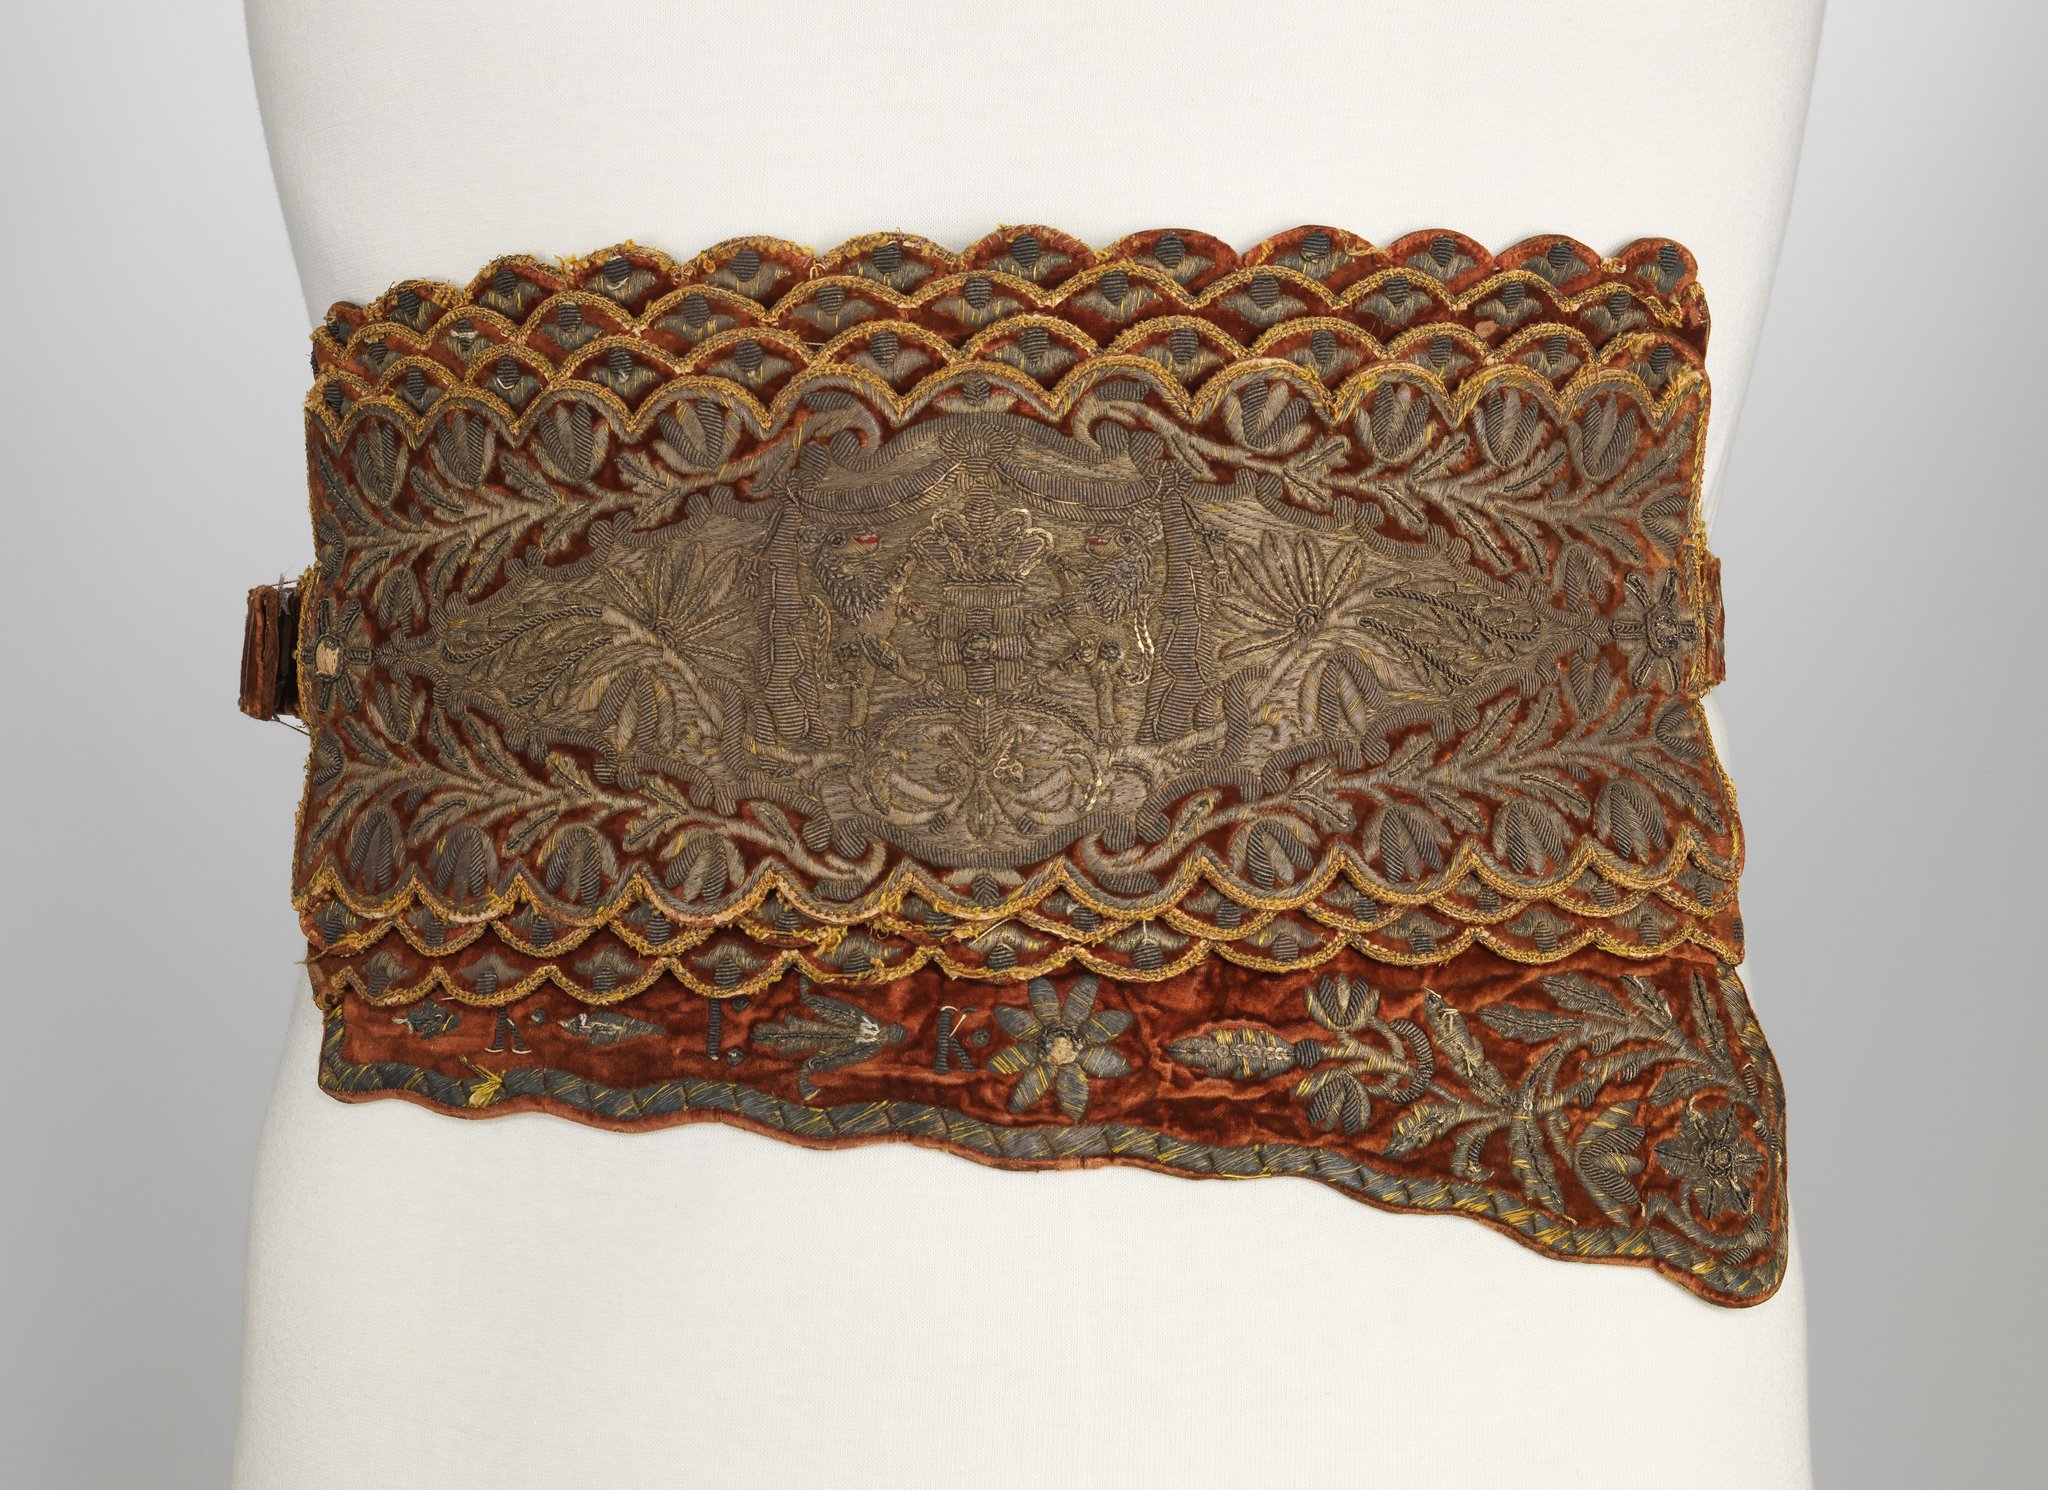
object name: belt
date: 1701-1733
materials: leather, metal, silk